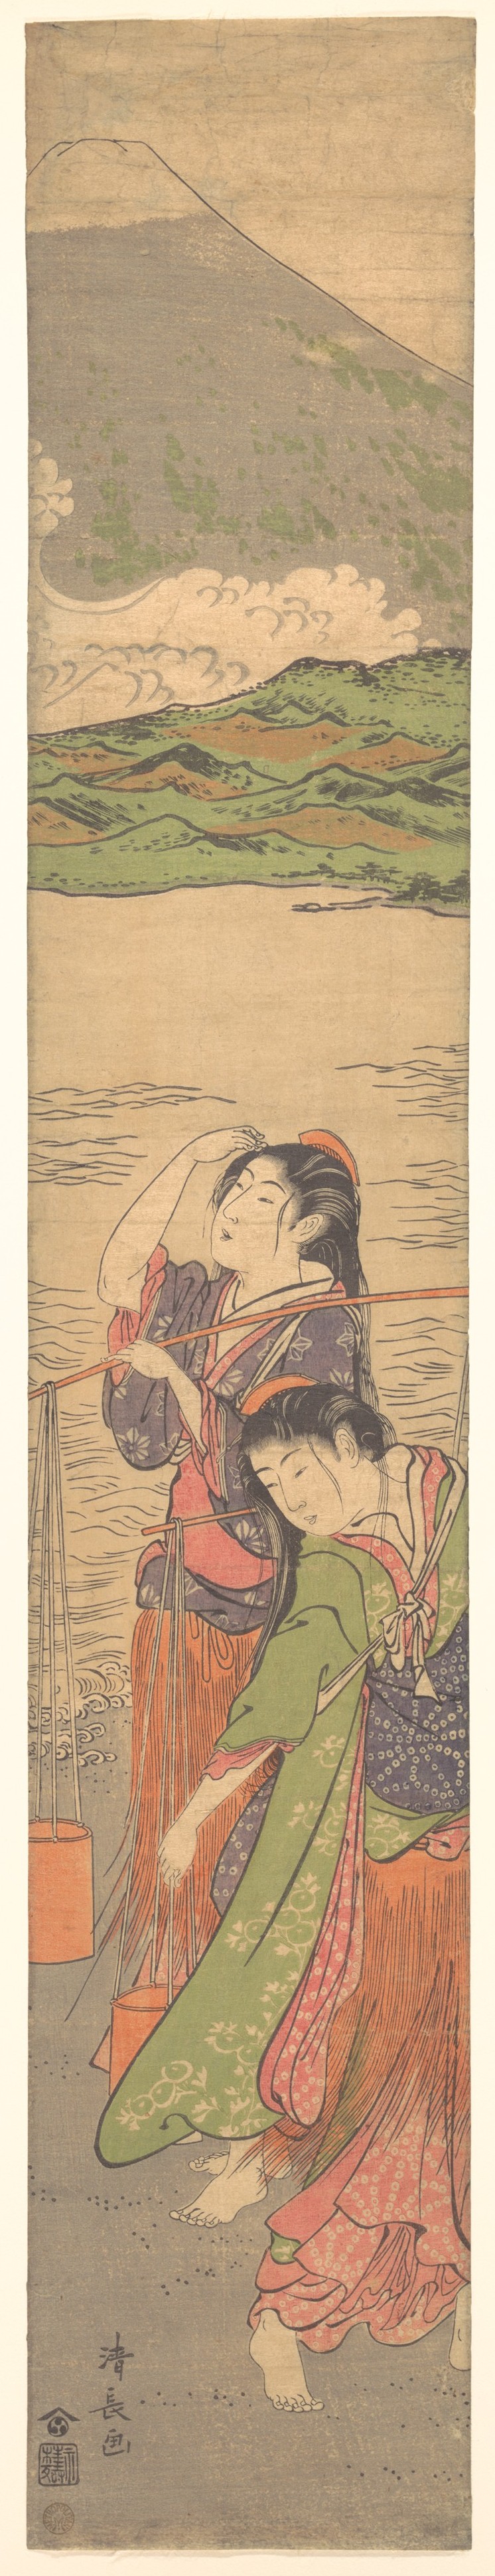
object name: print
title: Dance of the Beach Maidens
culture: japanese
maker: torii kiyonaga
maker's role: artist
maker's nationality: japanese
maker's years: 1752-1815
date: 1767-1800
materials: ink, paper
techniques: woodblock print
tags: dance,women,mountains